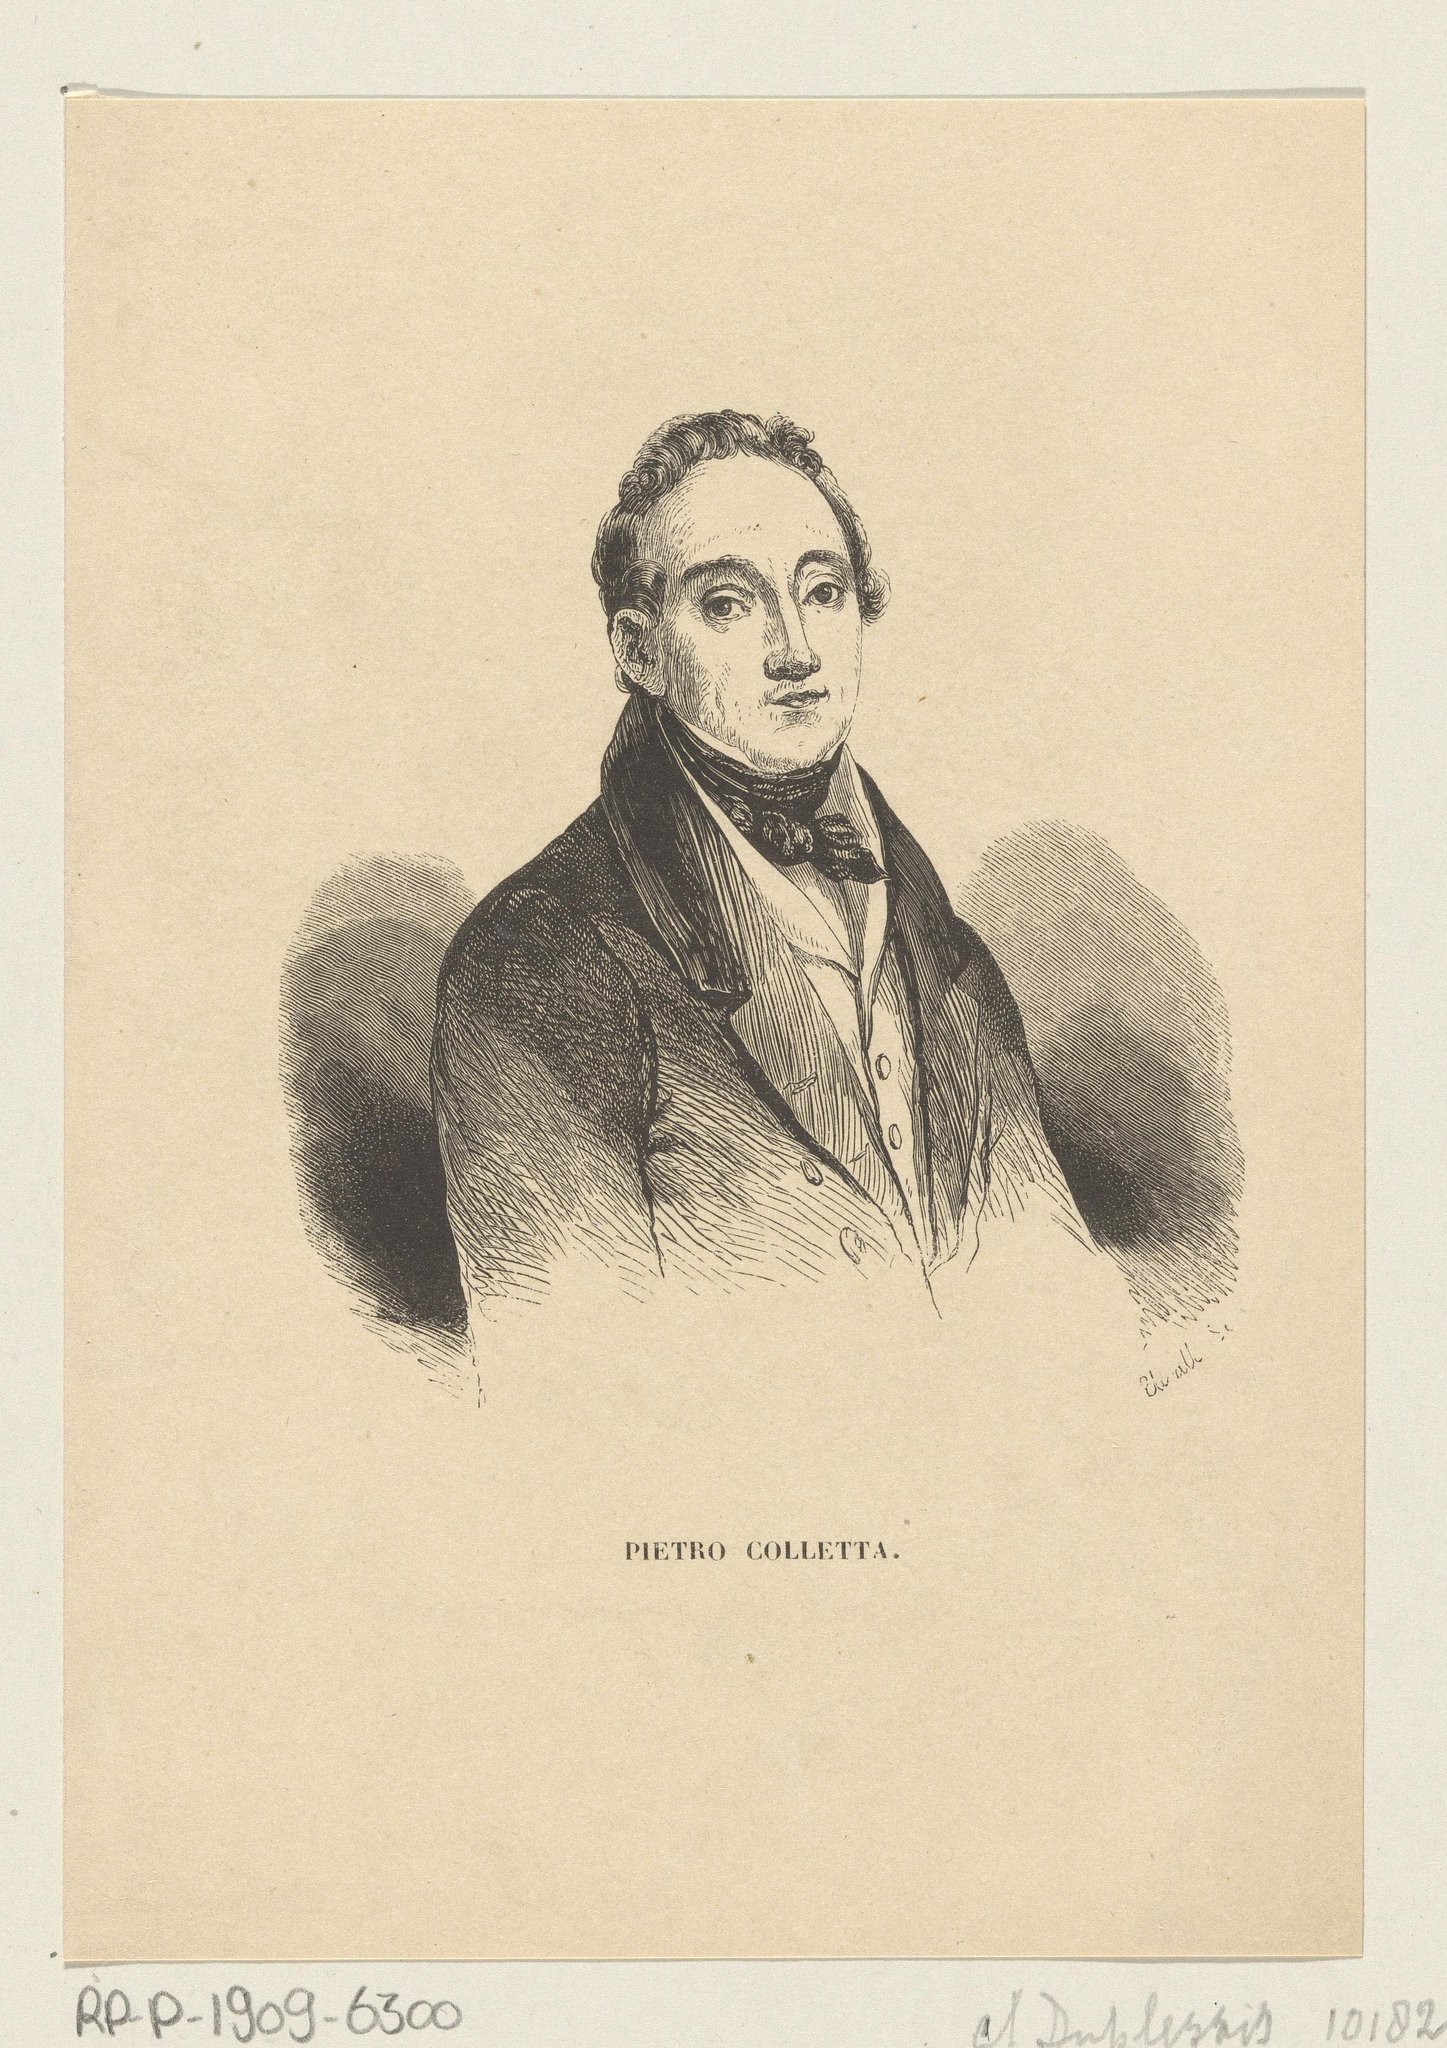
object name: print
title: Portret Pietro Coletta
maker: Anonymous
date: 1800-1870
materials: paper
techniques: engraving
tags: minister ~ government, commander-in-chief, general, marshal, historical persons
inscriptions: collector's mark: Lugt 2228, signature: ‘[..]all Sc.’